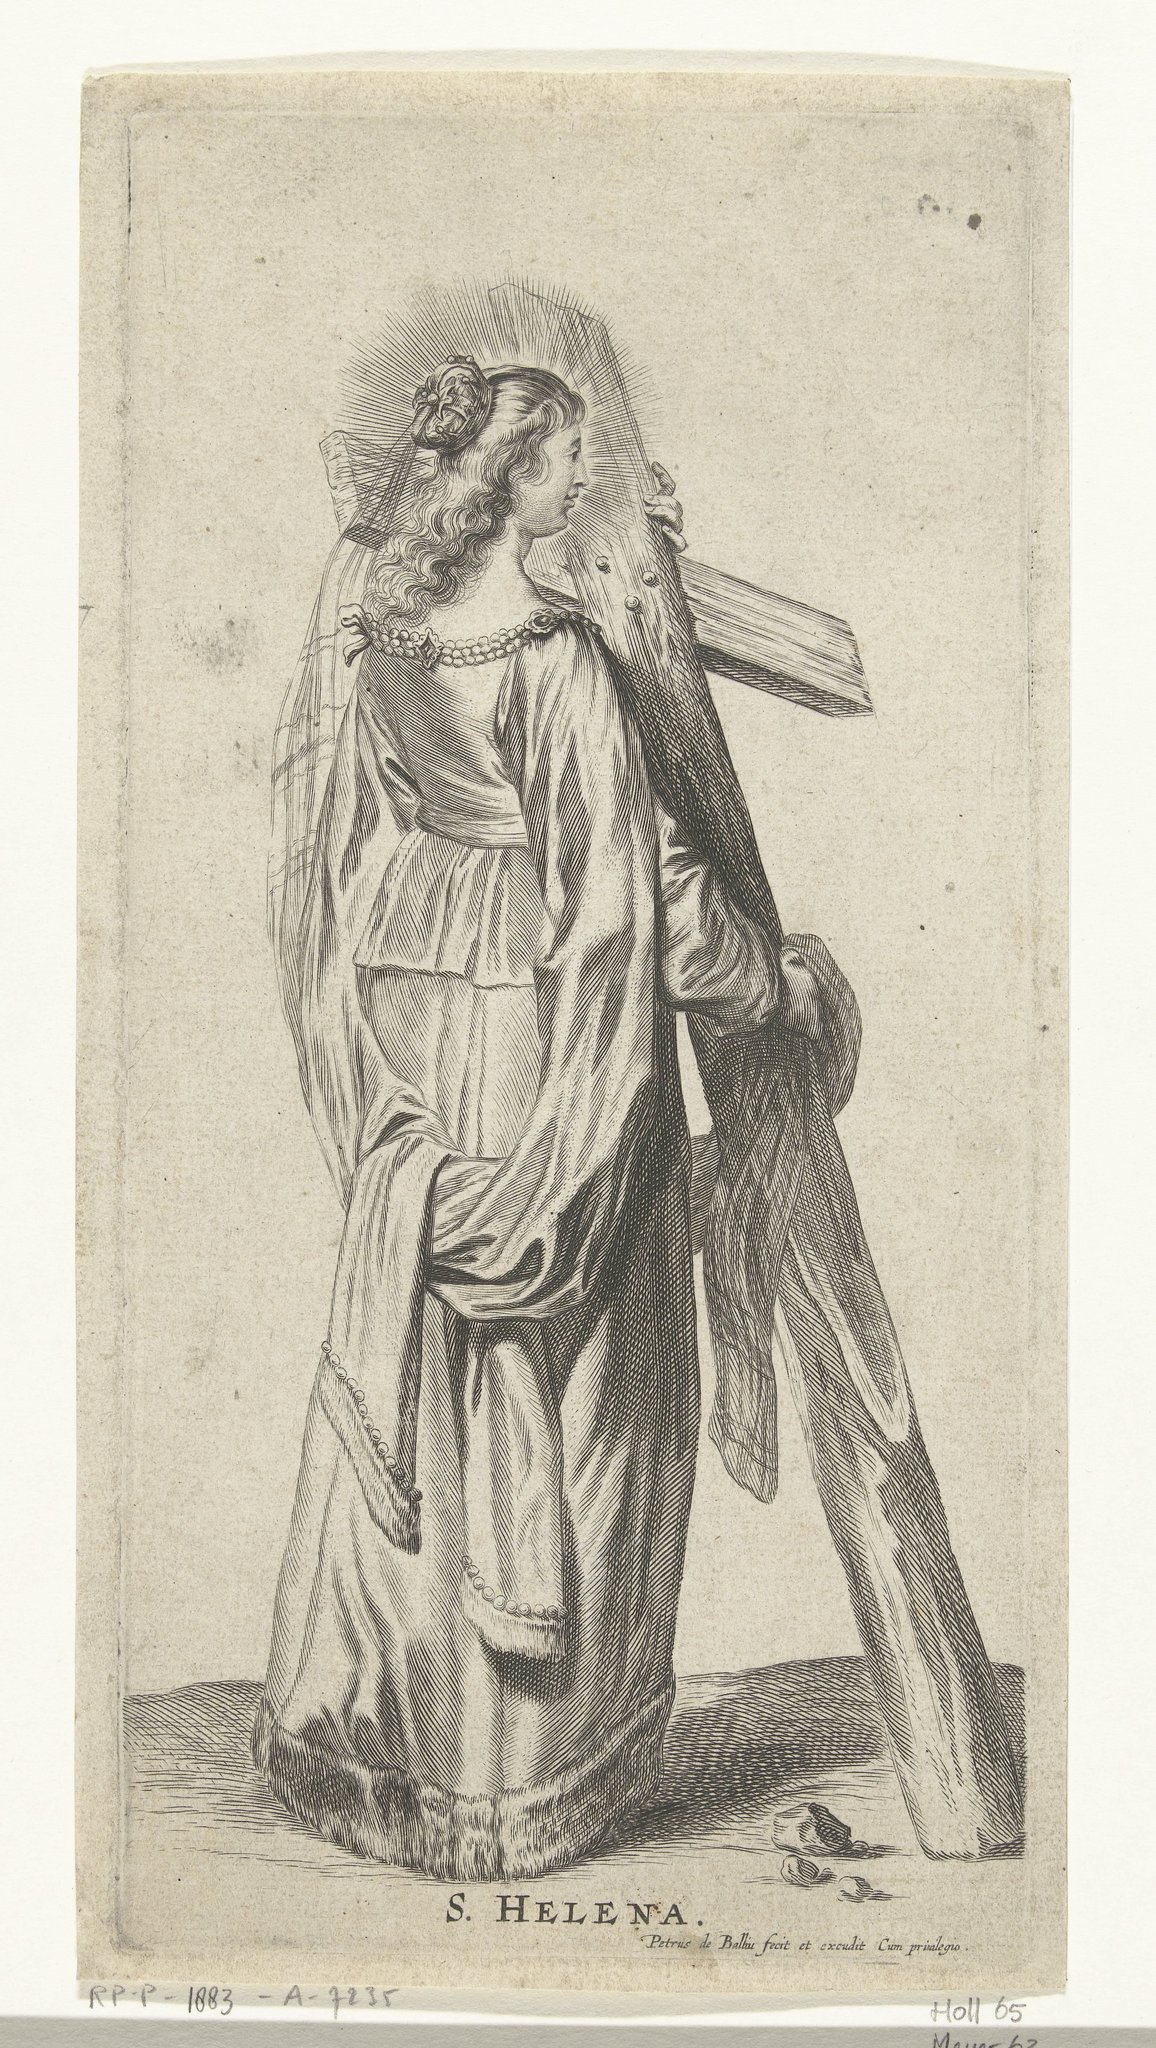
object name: print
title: S. Helena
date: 1623-1660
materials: paper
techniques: engraving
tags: empress helena, mother of constantine the great; possible attributes: model of church, (royal) crown, crown of thorns, cross, three nails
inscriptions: collector's mark: Lugt 2228